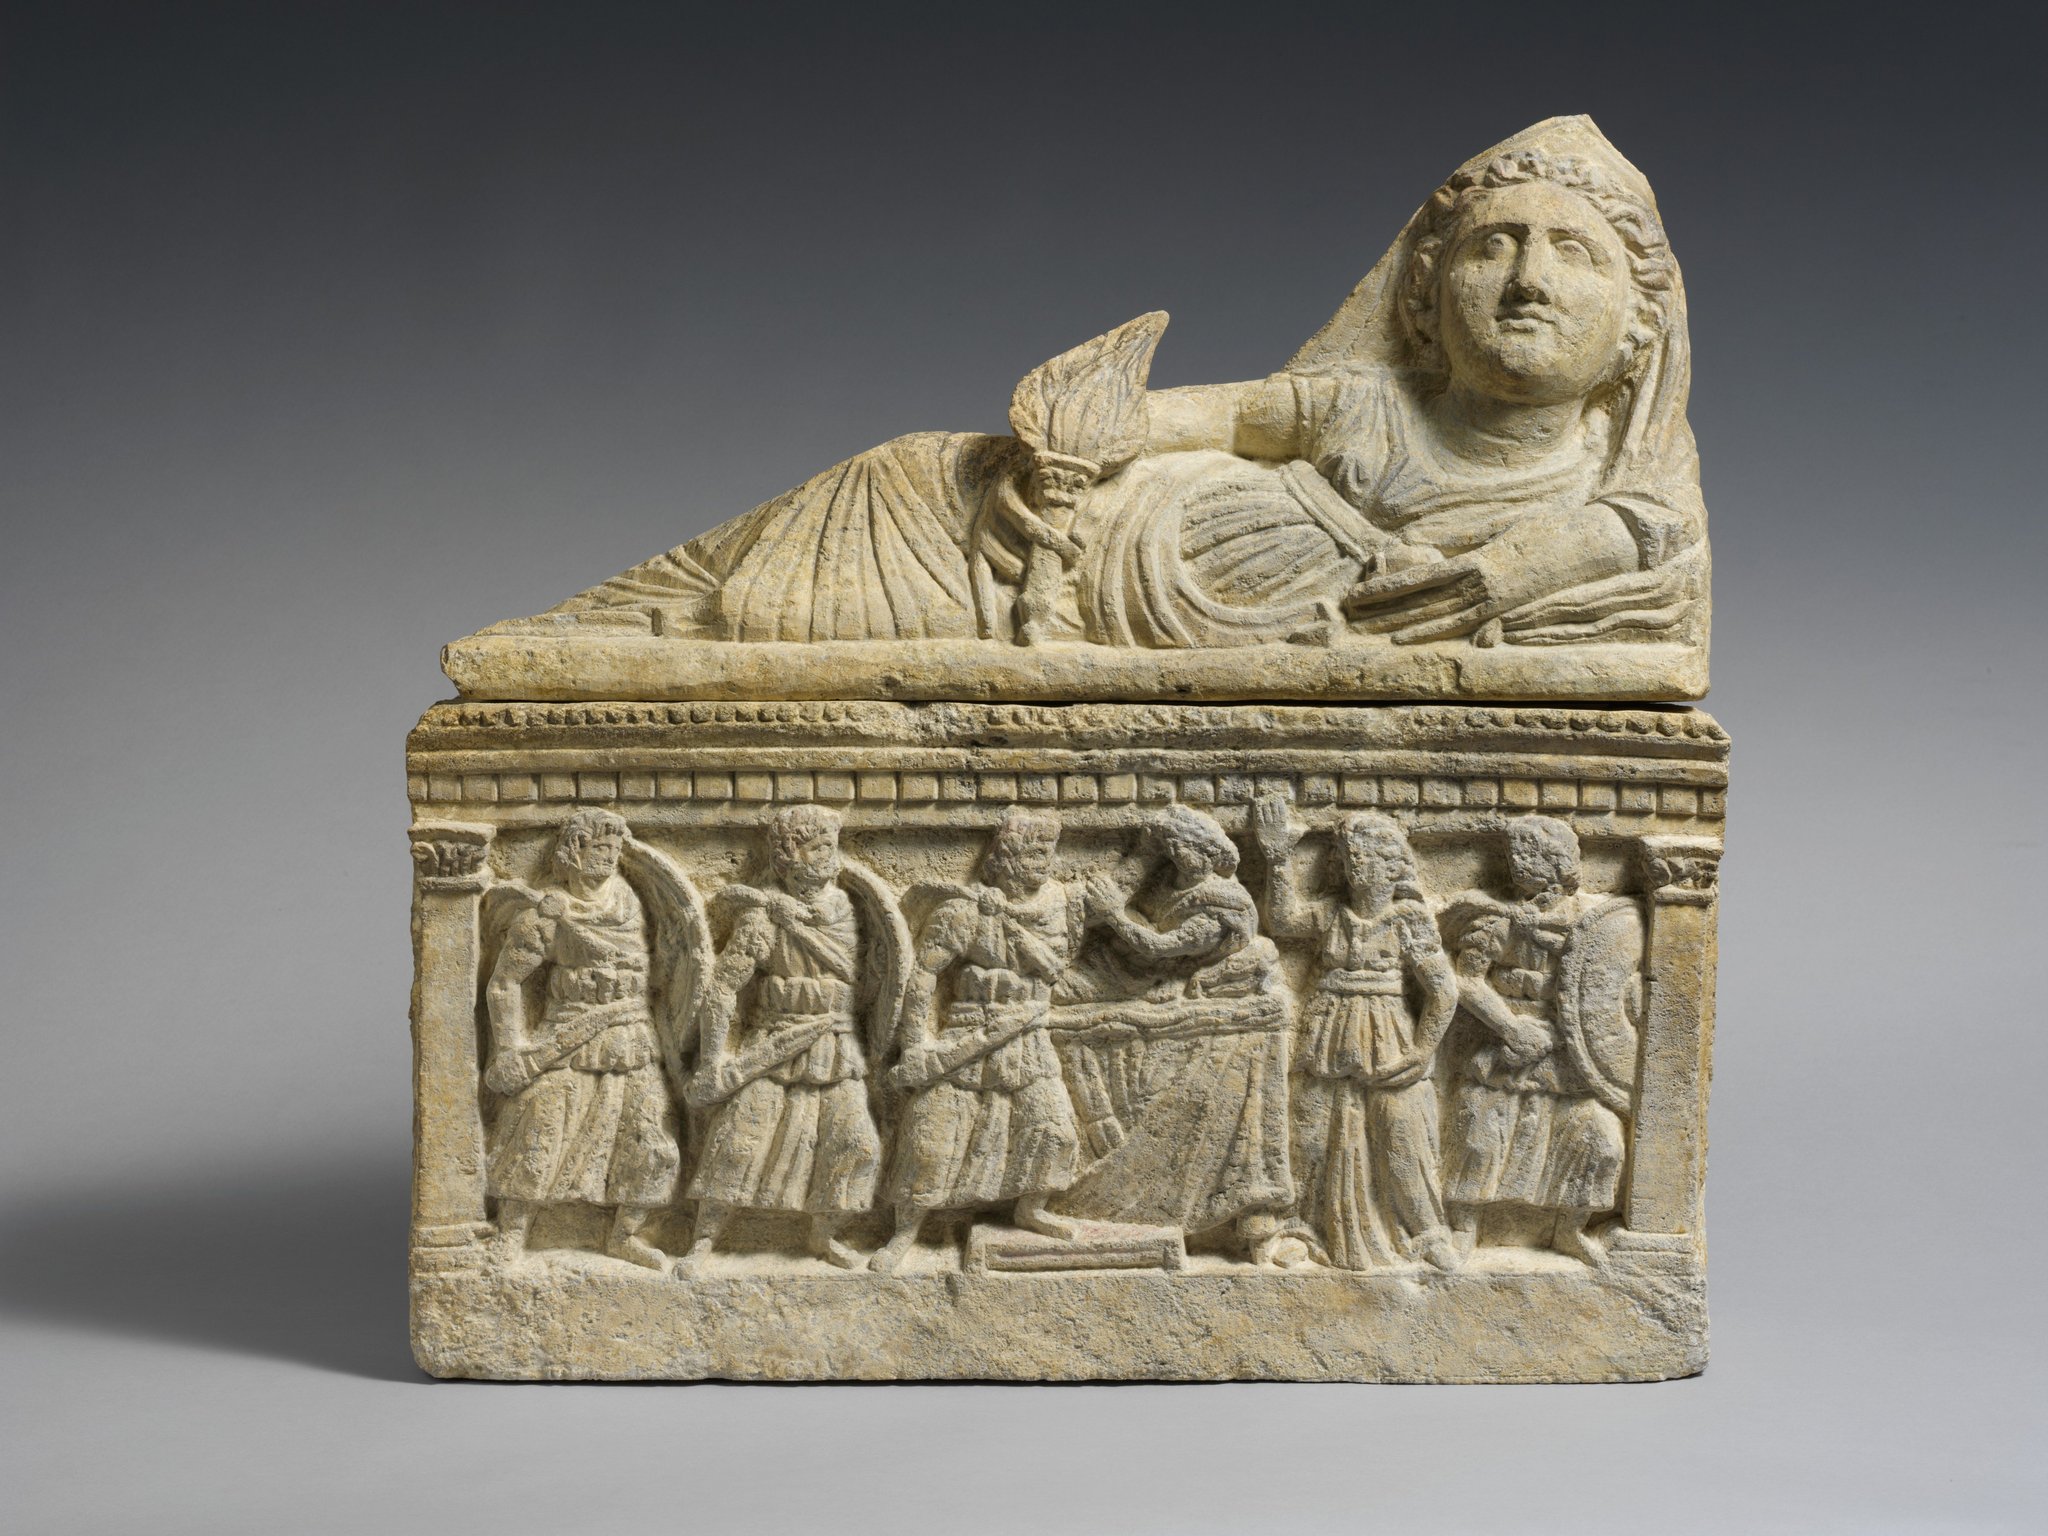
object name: cinerary urn with lid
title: Travertine cinerary urn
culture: etruscan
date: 200-101 BCE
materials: stone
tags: women